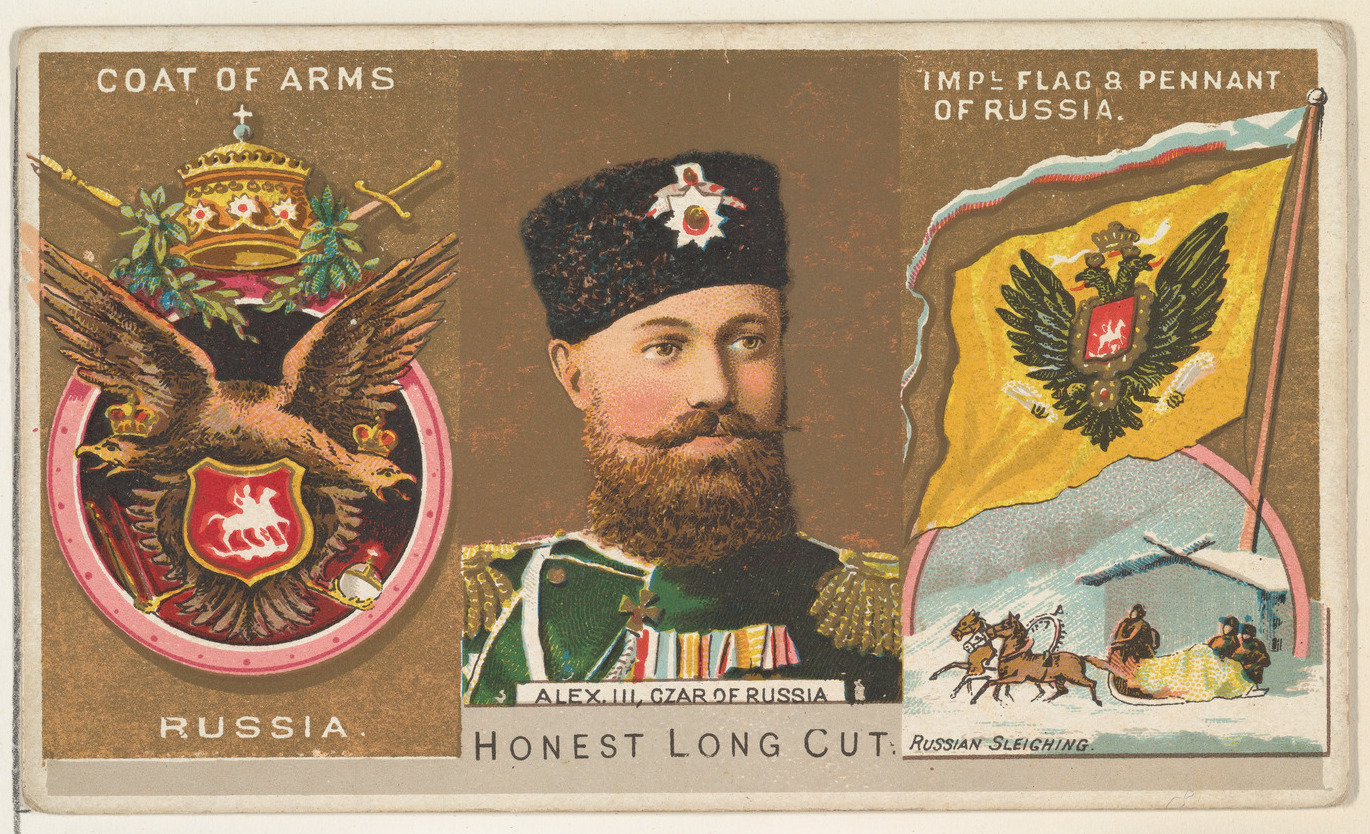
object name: print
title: Alexander III, Czar of Russia, from the Rulers, Flags, and Coats of Arms series (N126-1) issued by W. Duke, Sons & Co.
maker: w. duke, sons & co.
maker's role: publisher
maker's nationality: american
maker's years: 1870-1920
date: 1888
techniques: color lithograph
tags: men,portraits,coat of arms,flags